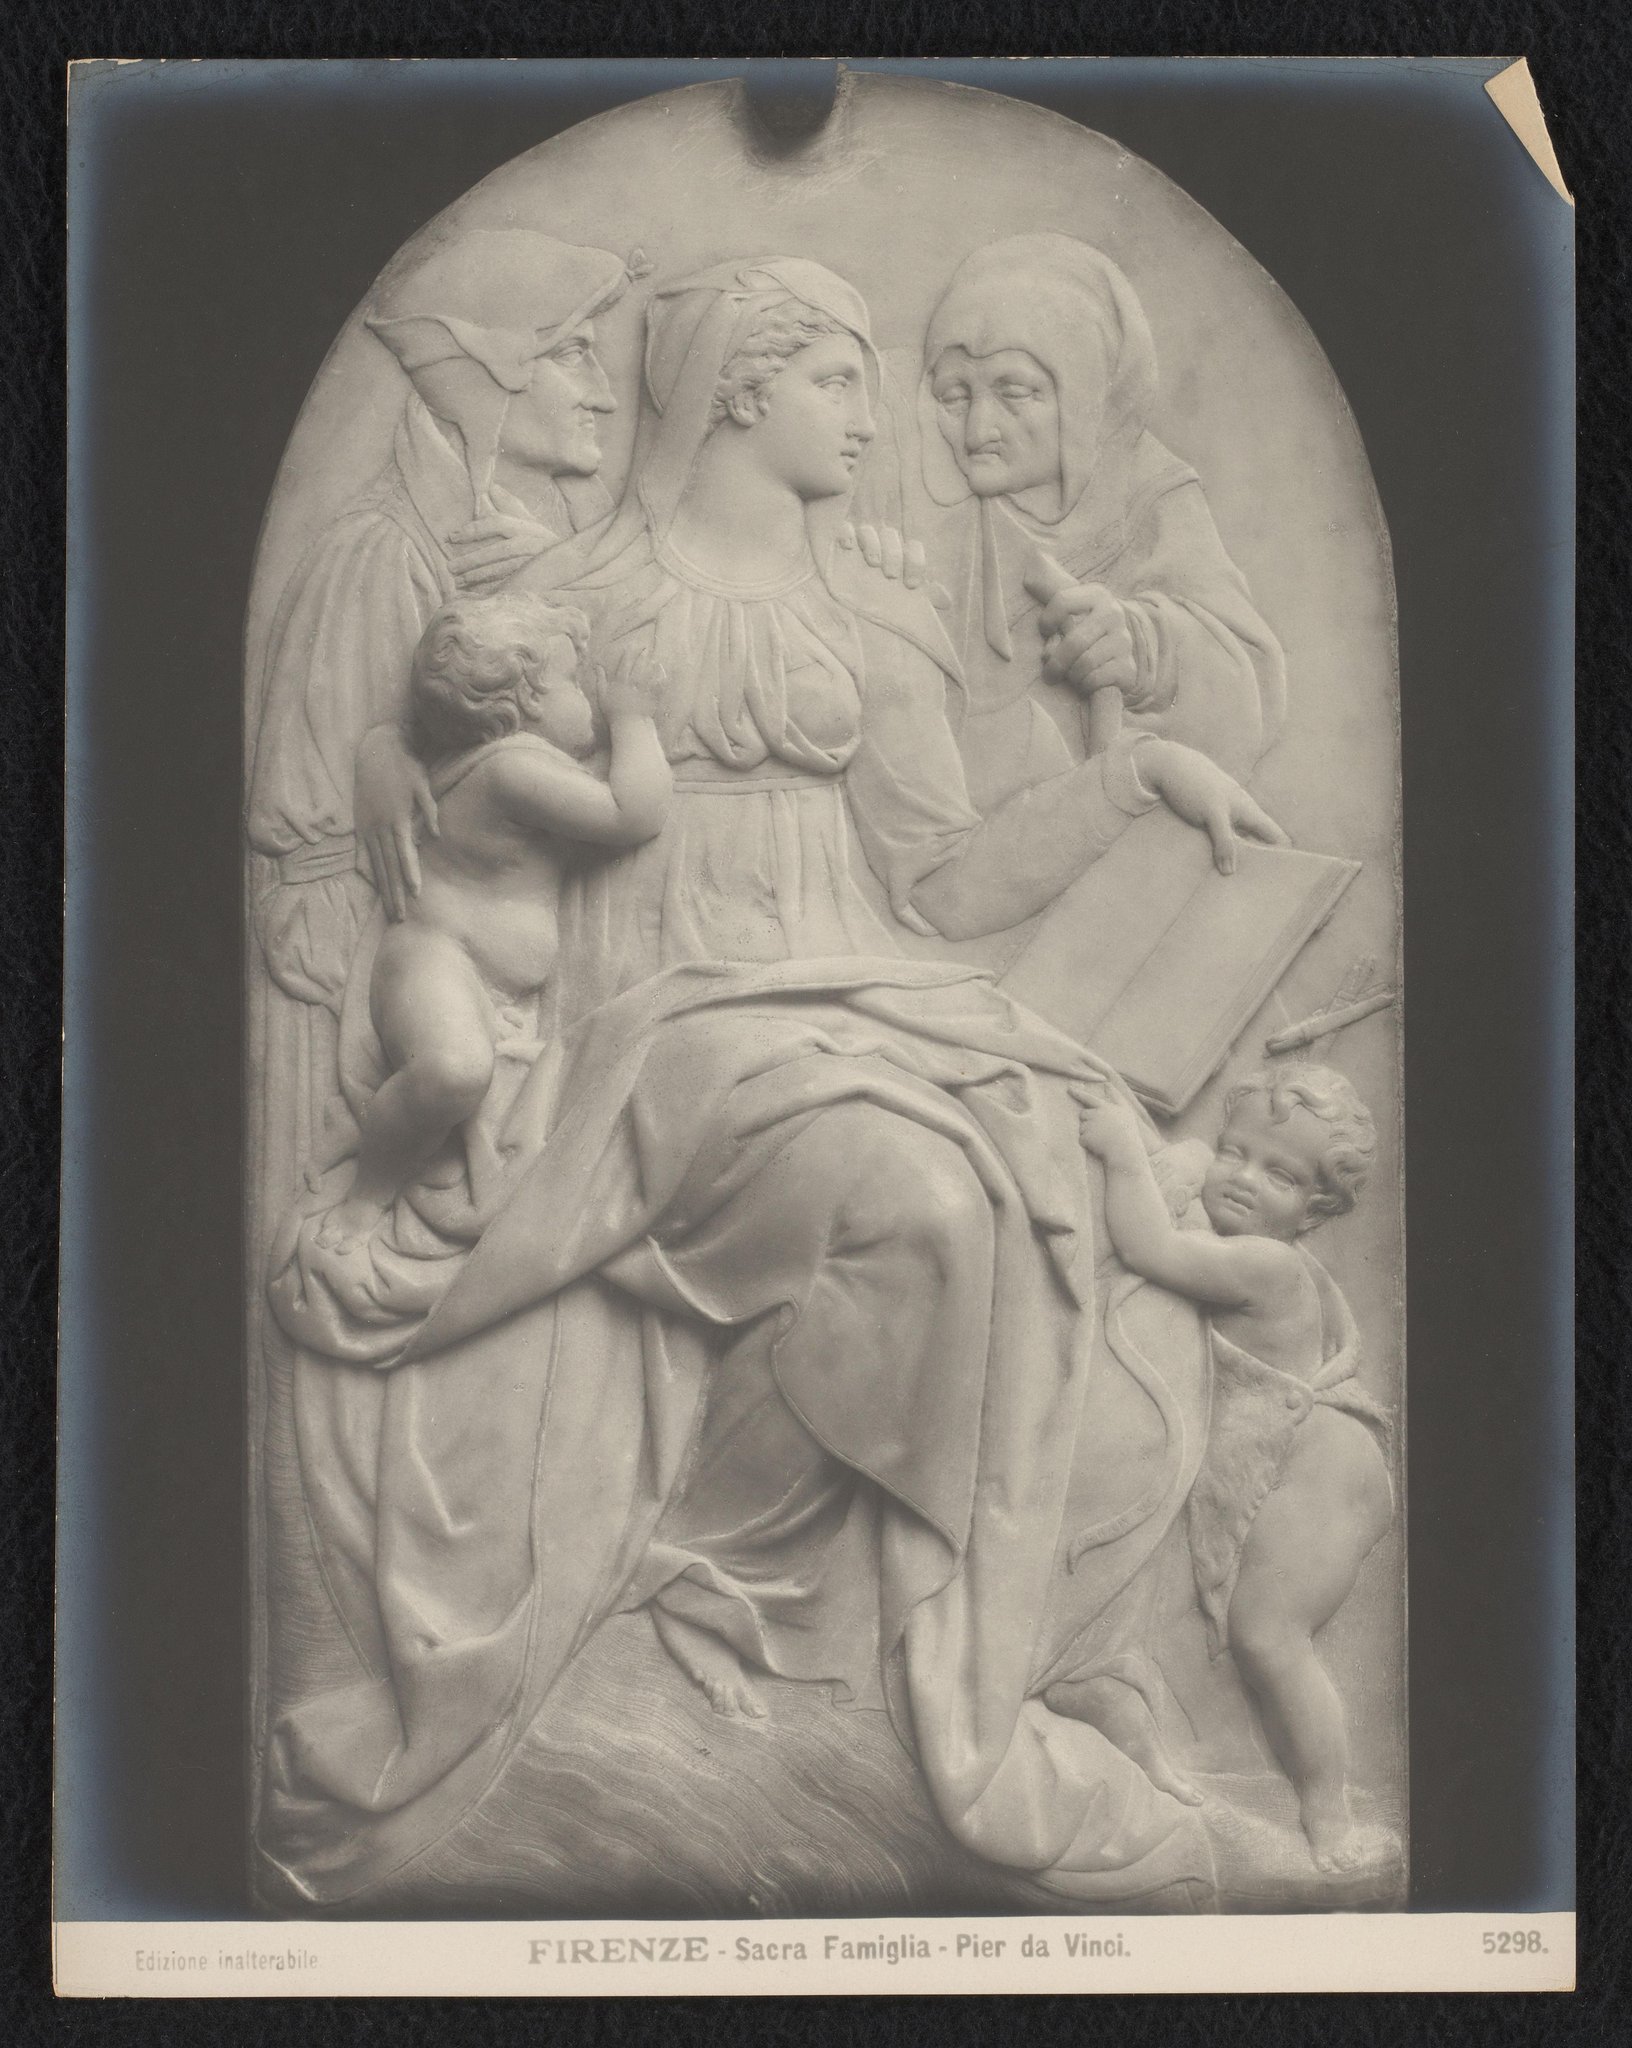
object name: photograph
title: Reliëf van de heilige familie door Pierino da Vinci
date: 1901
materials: paper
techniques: gelatin silver print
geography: berlin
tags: interior ~ representation of a building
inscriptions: number: ‘5298.’, inscription: ‘Edizione inalterabile.’, collector's mark: ‘RIJKS SCHOOL VOOR KUNSTNIJVERHEID/ GROEP’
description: Deze foto maakt deel uit van een omslag.